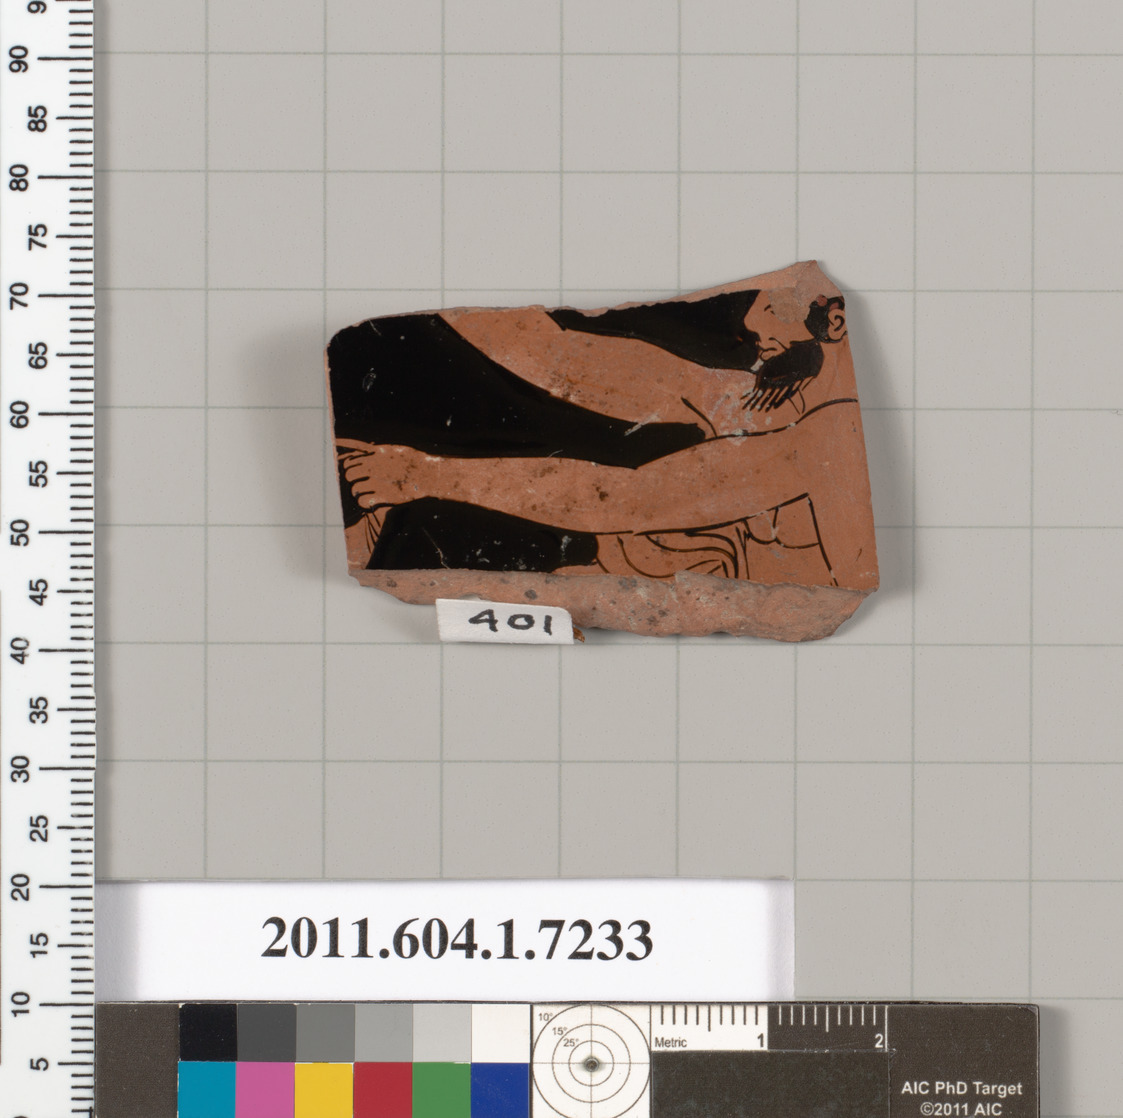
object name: kylix fragment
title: Terracotta fragment of a kylix (drinking cup)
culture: greek, attic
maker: makron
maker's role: artist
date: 500-480 BCE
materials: terracotta